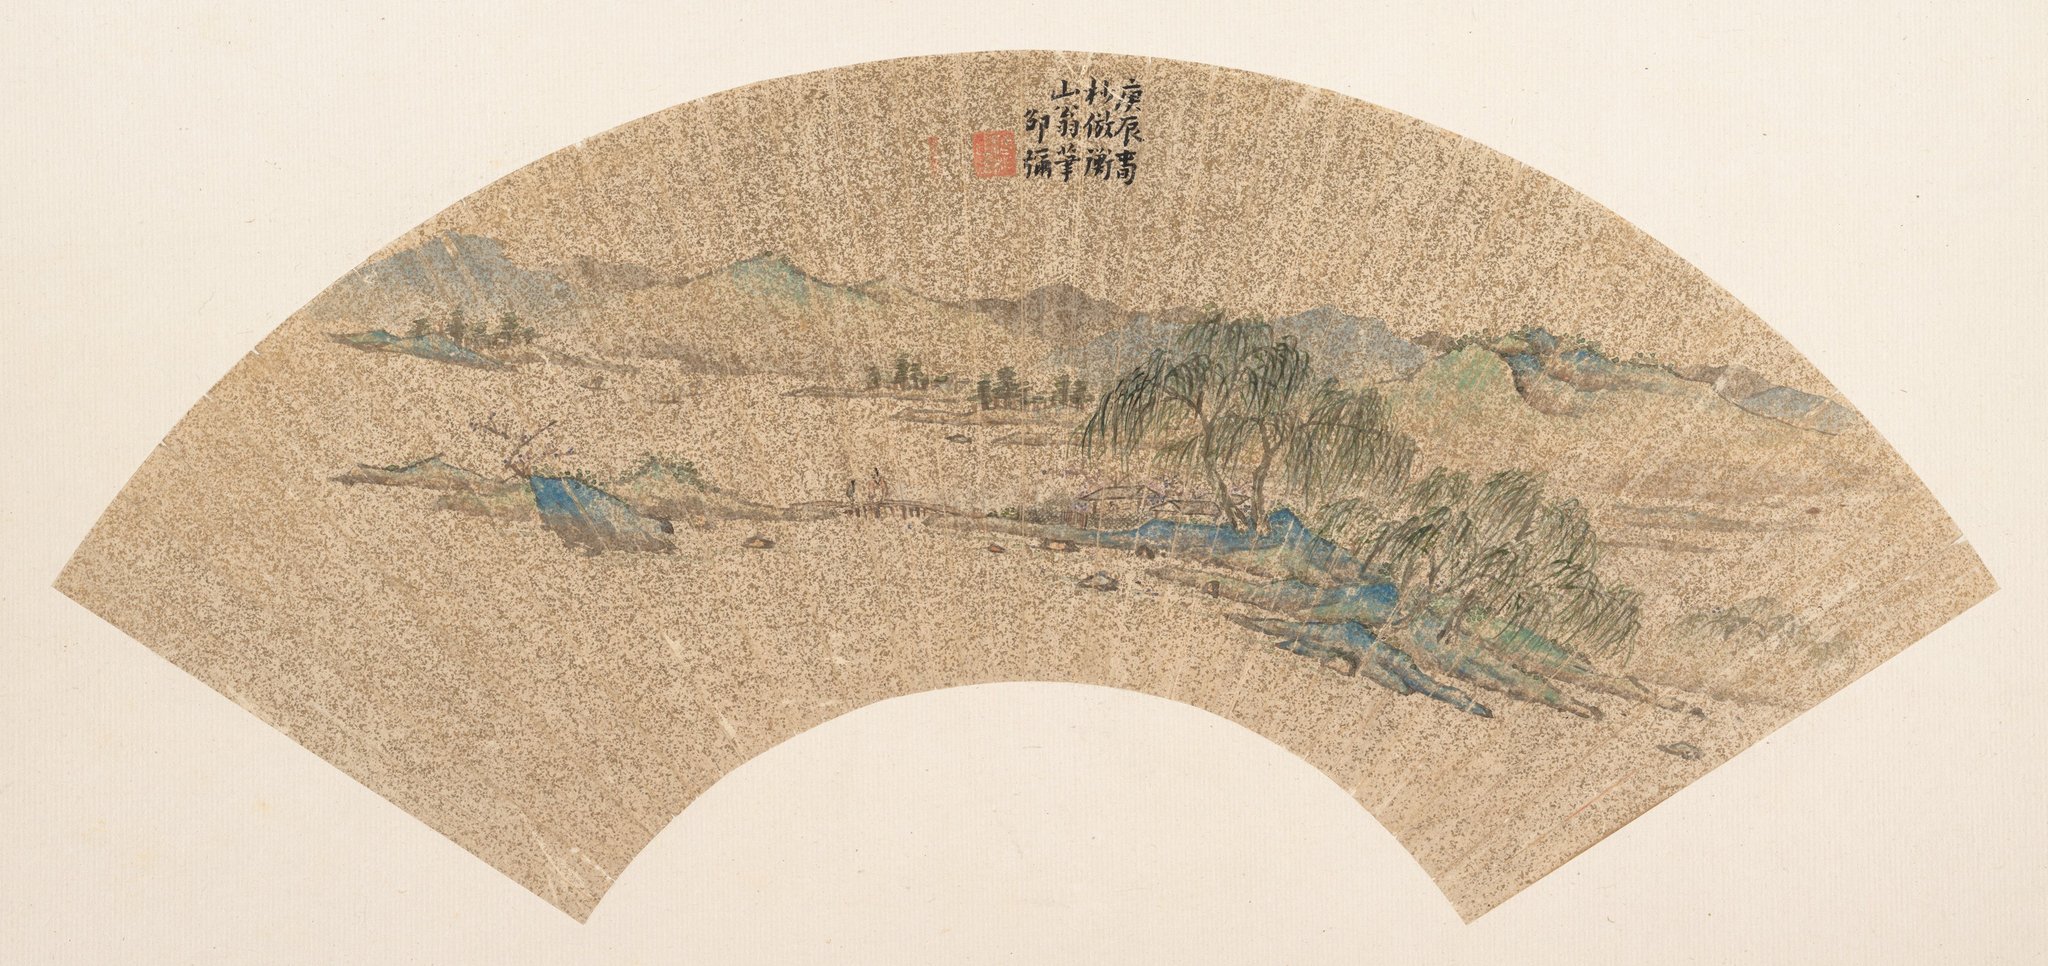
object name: folding fan mounted a an album leaf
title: Landscape After Wen Zhengming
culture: chinese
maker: shao mi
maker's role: artist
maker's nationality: chinese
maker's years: 1620-1660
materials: gold, ink, paper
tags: landscapes